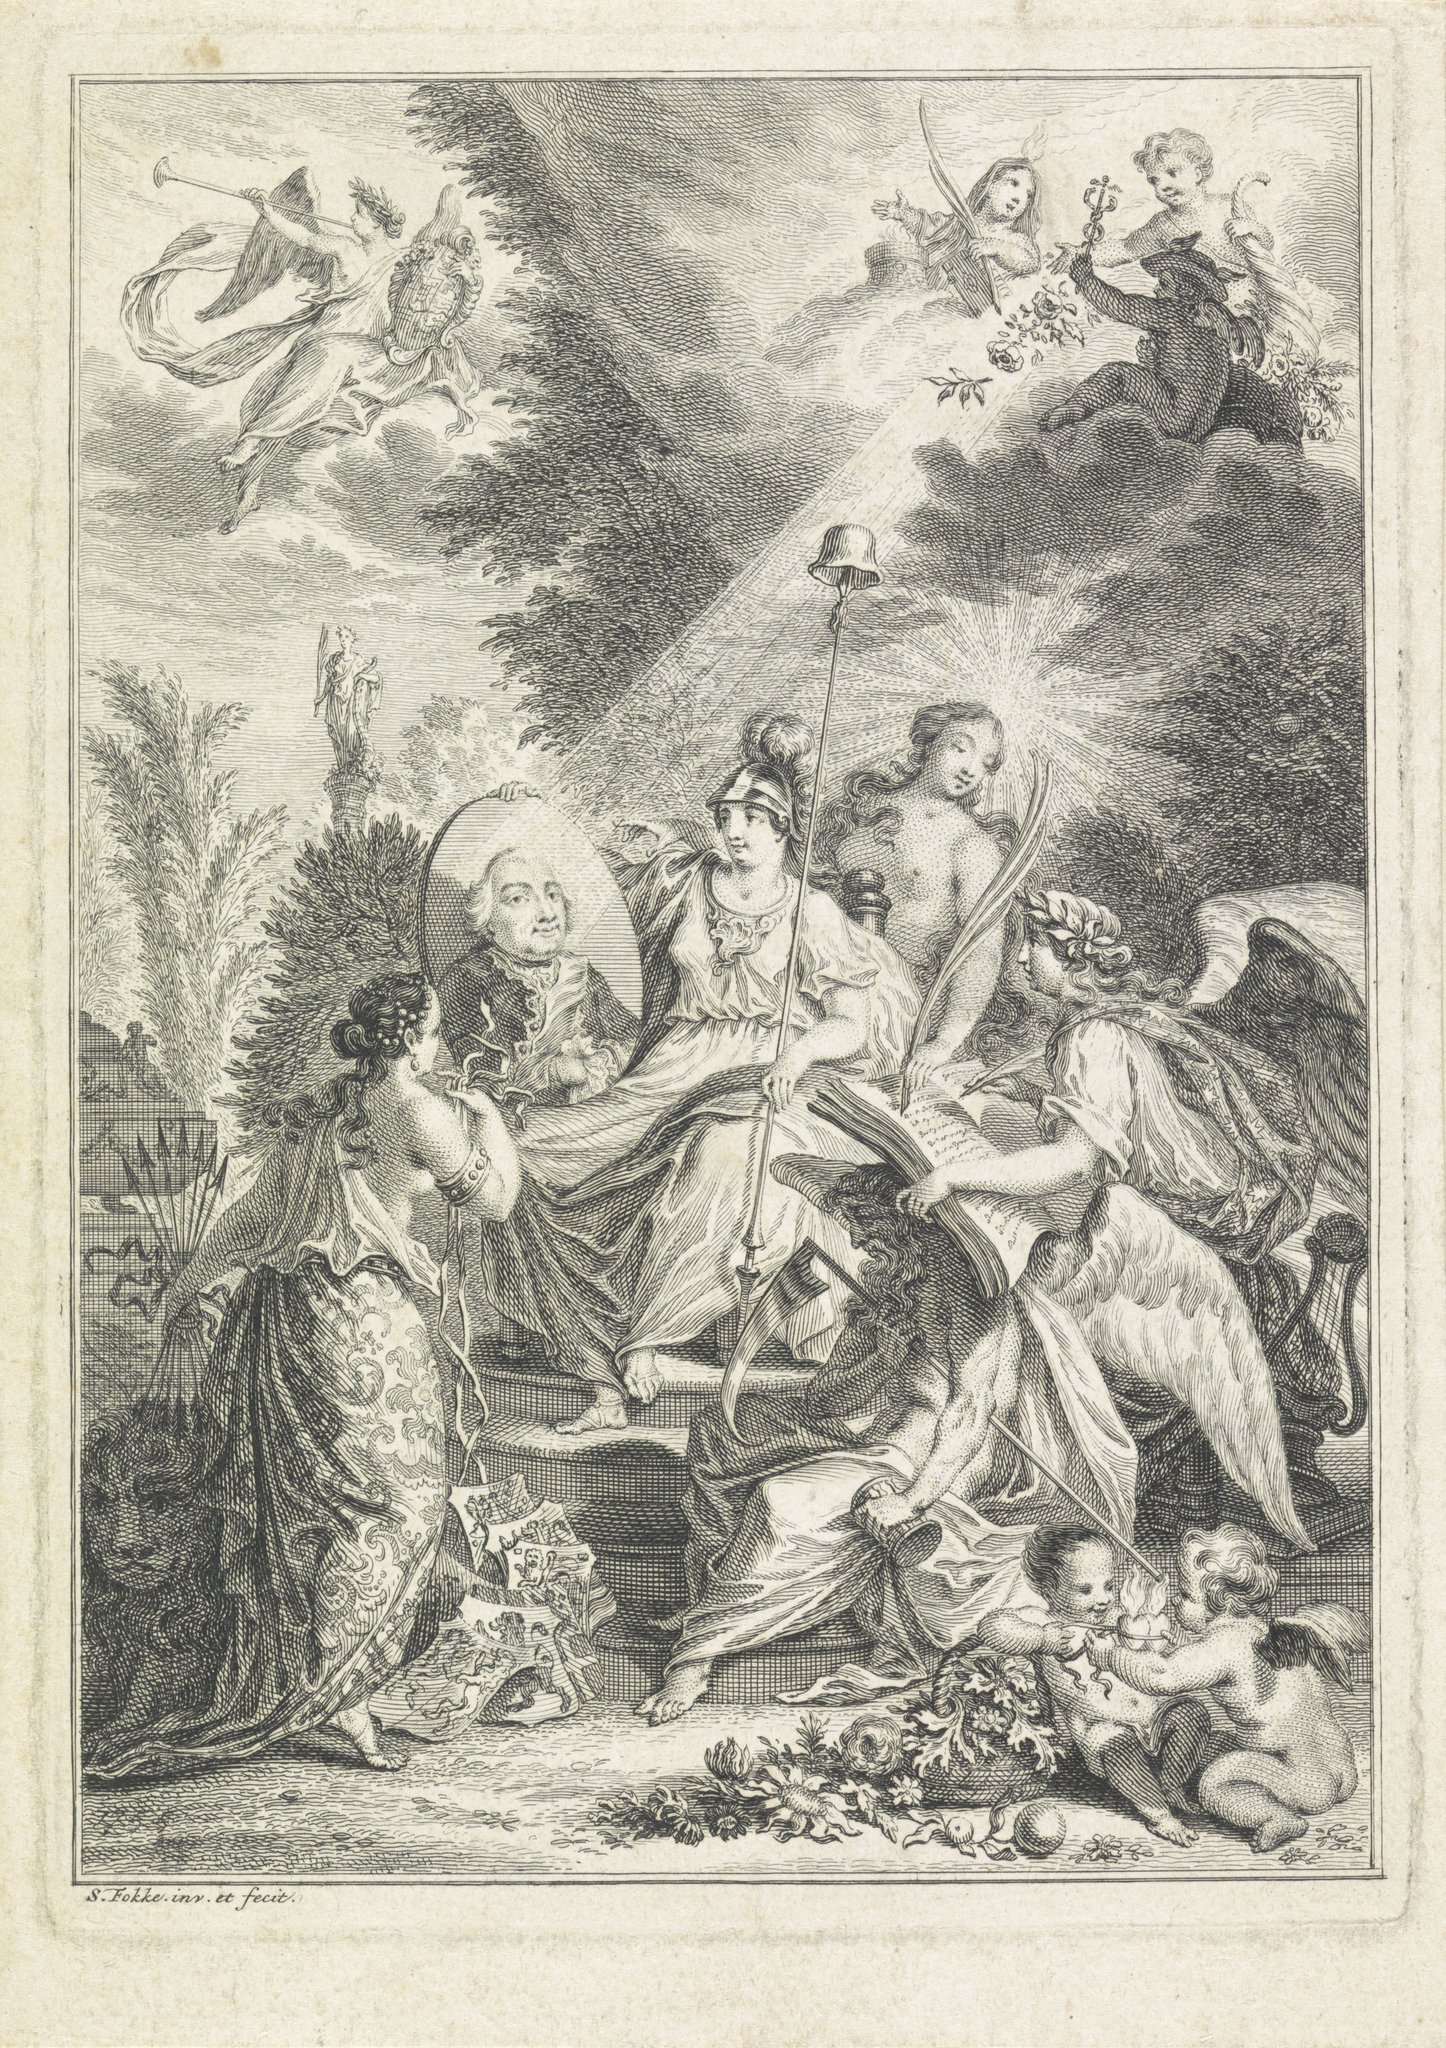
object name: print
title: Portret van Willem IV, prins van Oranje-Nassau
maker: simon fokke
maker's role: draughtsman, print maker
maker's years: 1712-1784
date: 1747-1784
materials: paper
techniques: engraving, etching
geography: amsterdam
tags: the hague, willem iv (prins van oranje-nassau), fame; 'fama', 'fama buona', 'fama chiara' (ripa) (+ abstract concept represented by female figure)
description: Portret van Willem IV in een ovaal. Daar omheen meerdere allegorische figuren en objecten, waaronder Minerva en de Nederlandse Maagd. De Waarheid helpt Geschiedenis met het schrijven in een boek dat rust op de schouders van de Tijd. In de wolken Faam en putti.